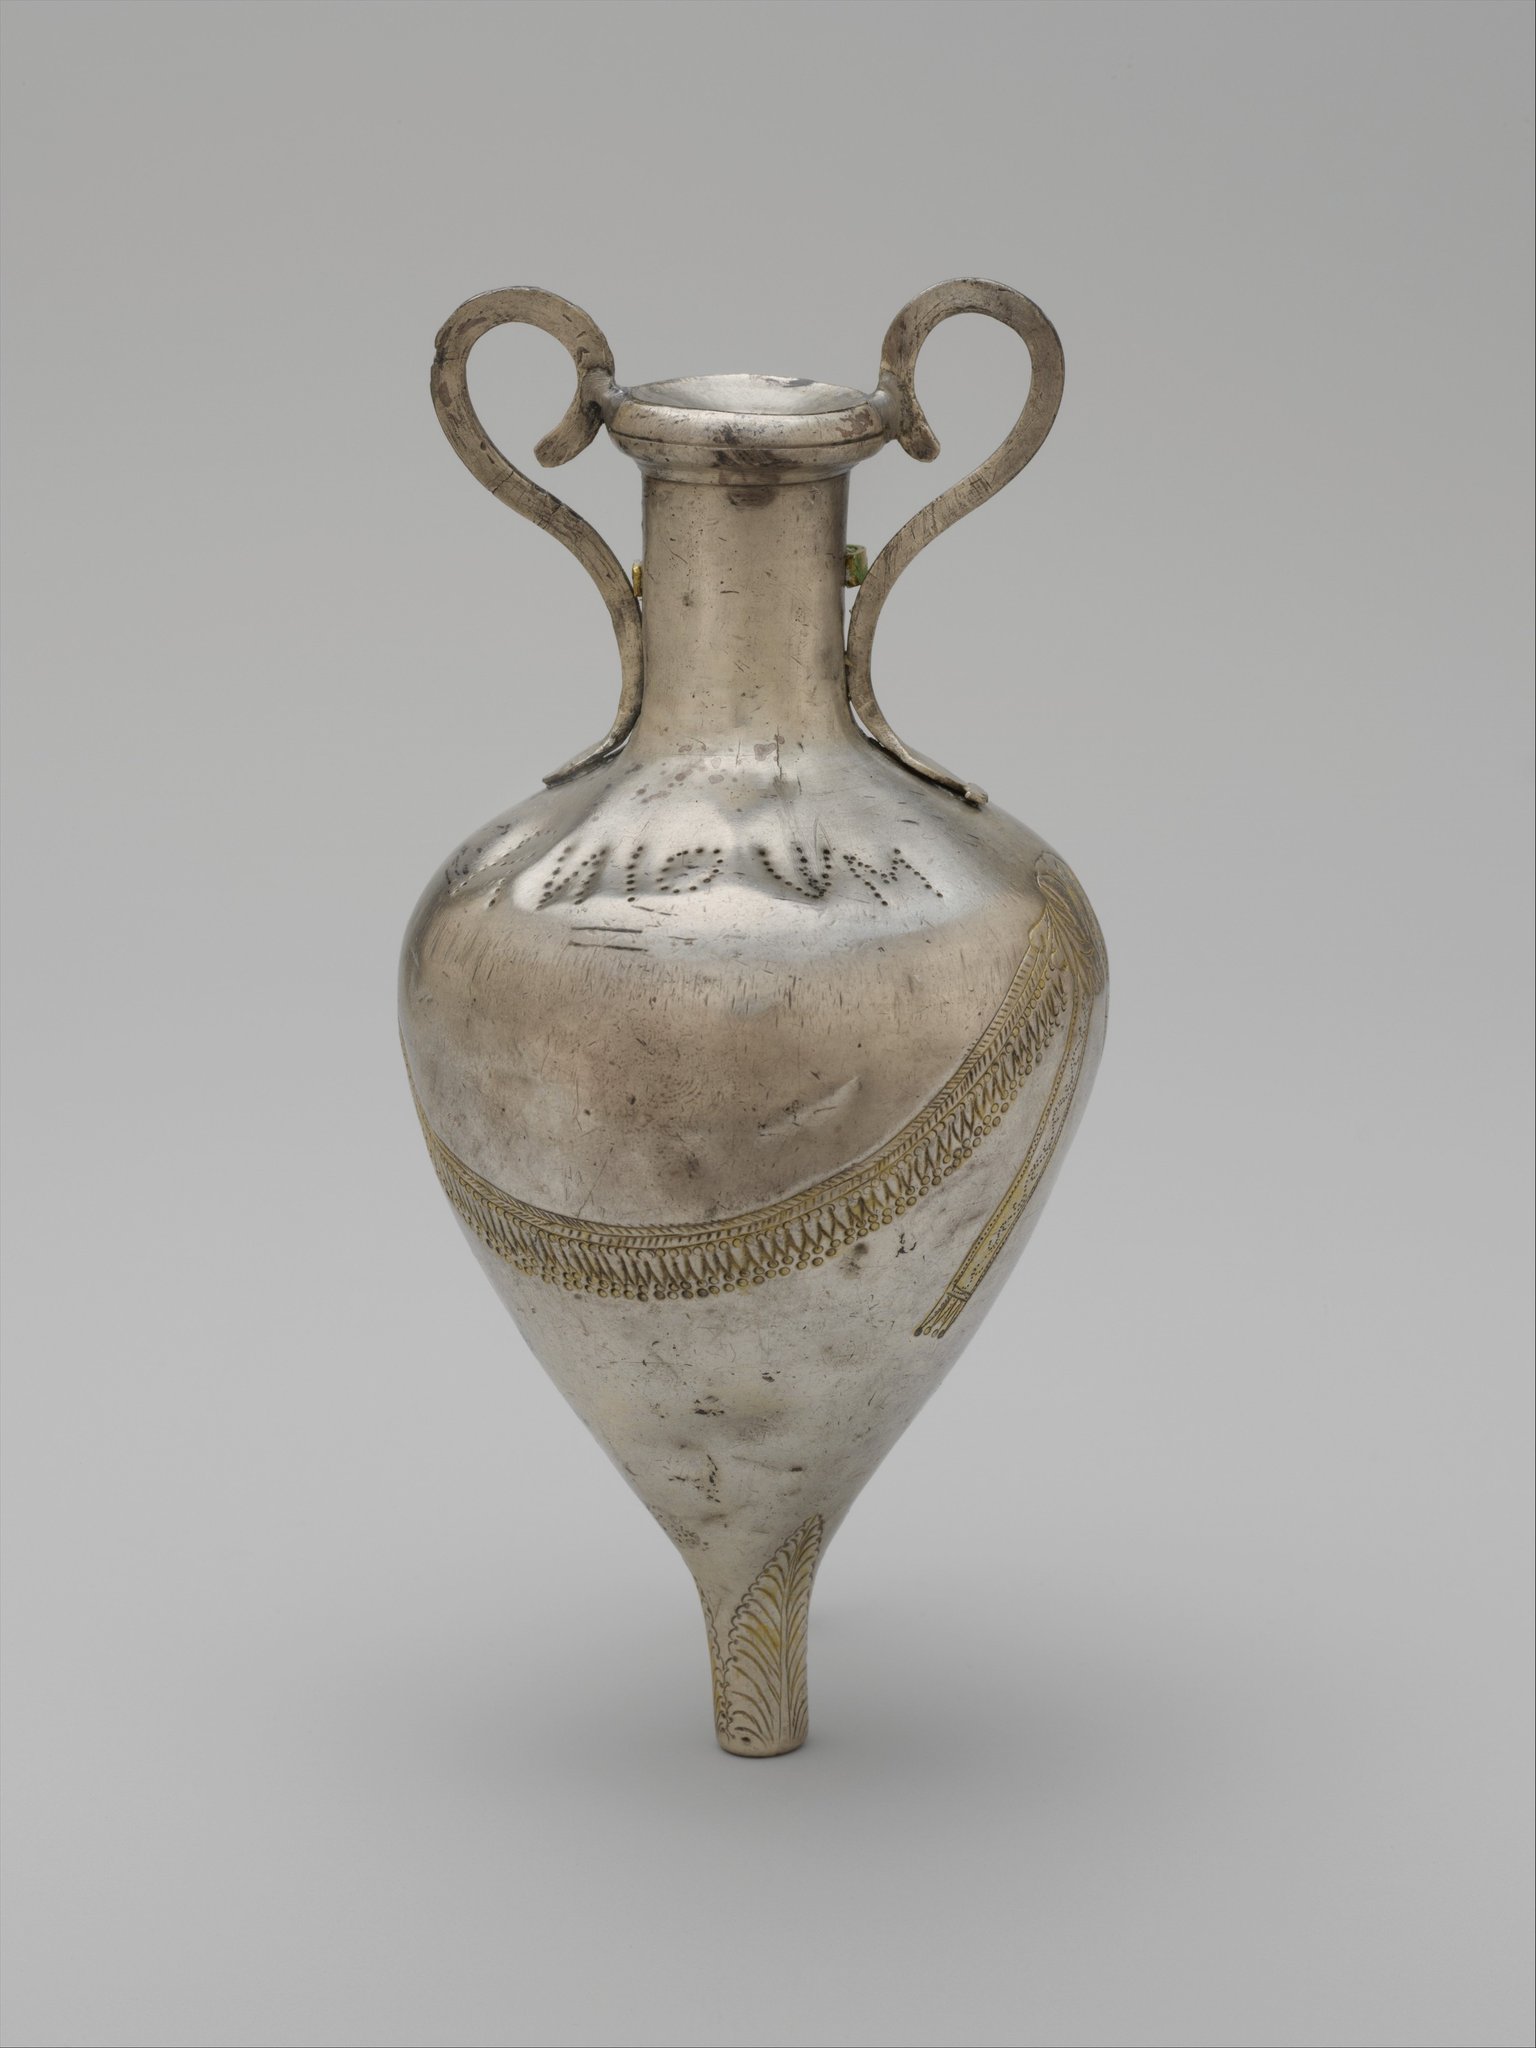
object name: amphoriskos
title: Silver and gilt amphoriskos (scented oil flask)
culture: apulian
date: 300-268 BCE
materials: gold, silver